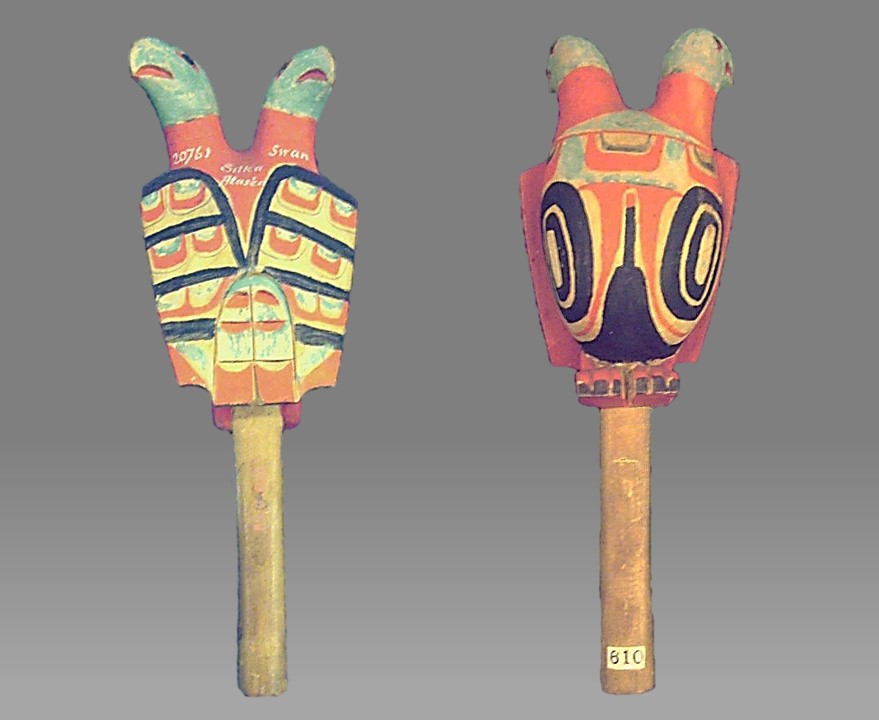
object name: cecoq rattle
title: Cecoq (rattle)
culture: native american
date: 1834-1866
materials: wood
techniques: polychrome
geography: united states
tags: birds